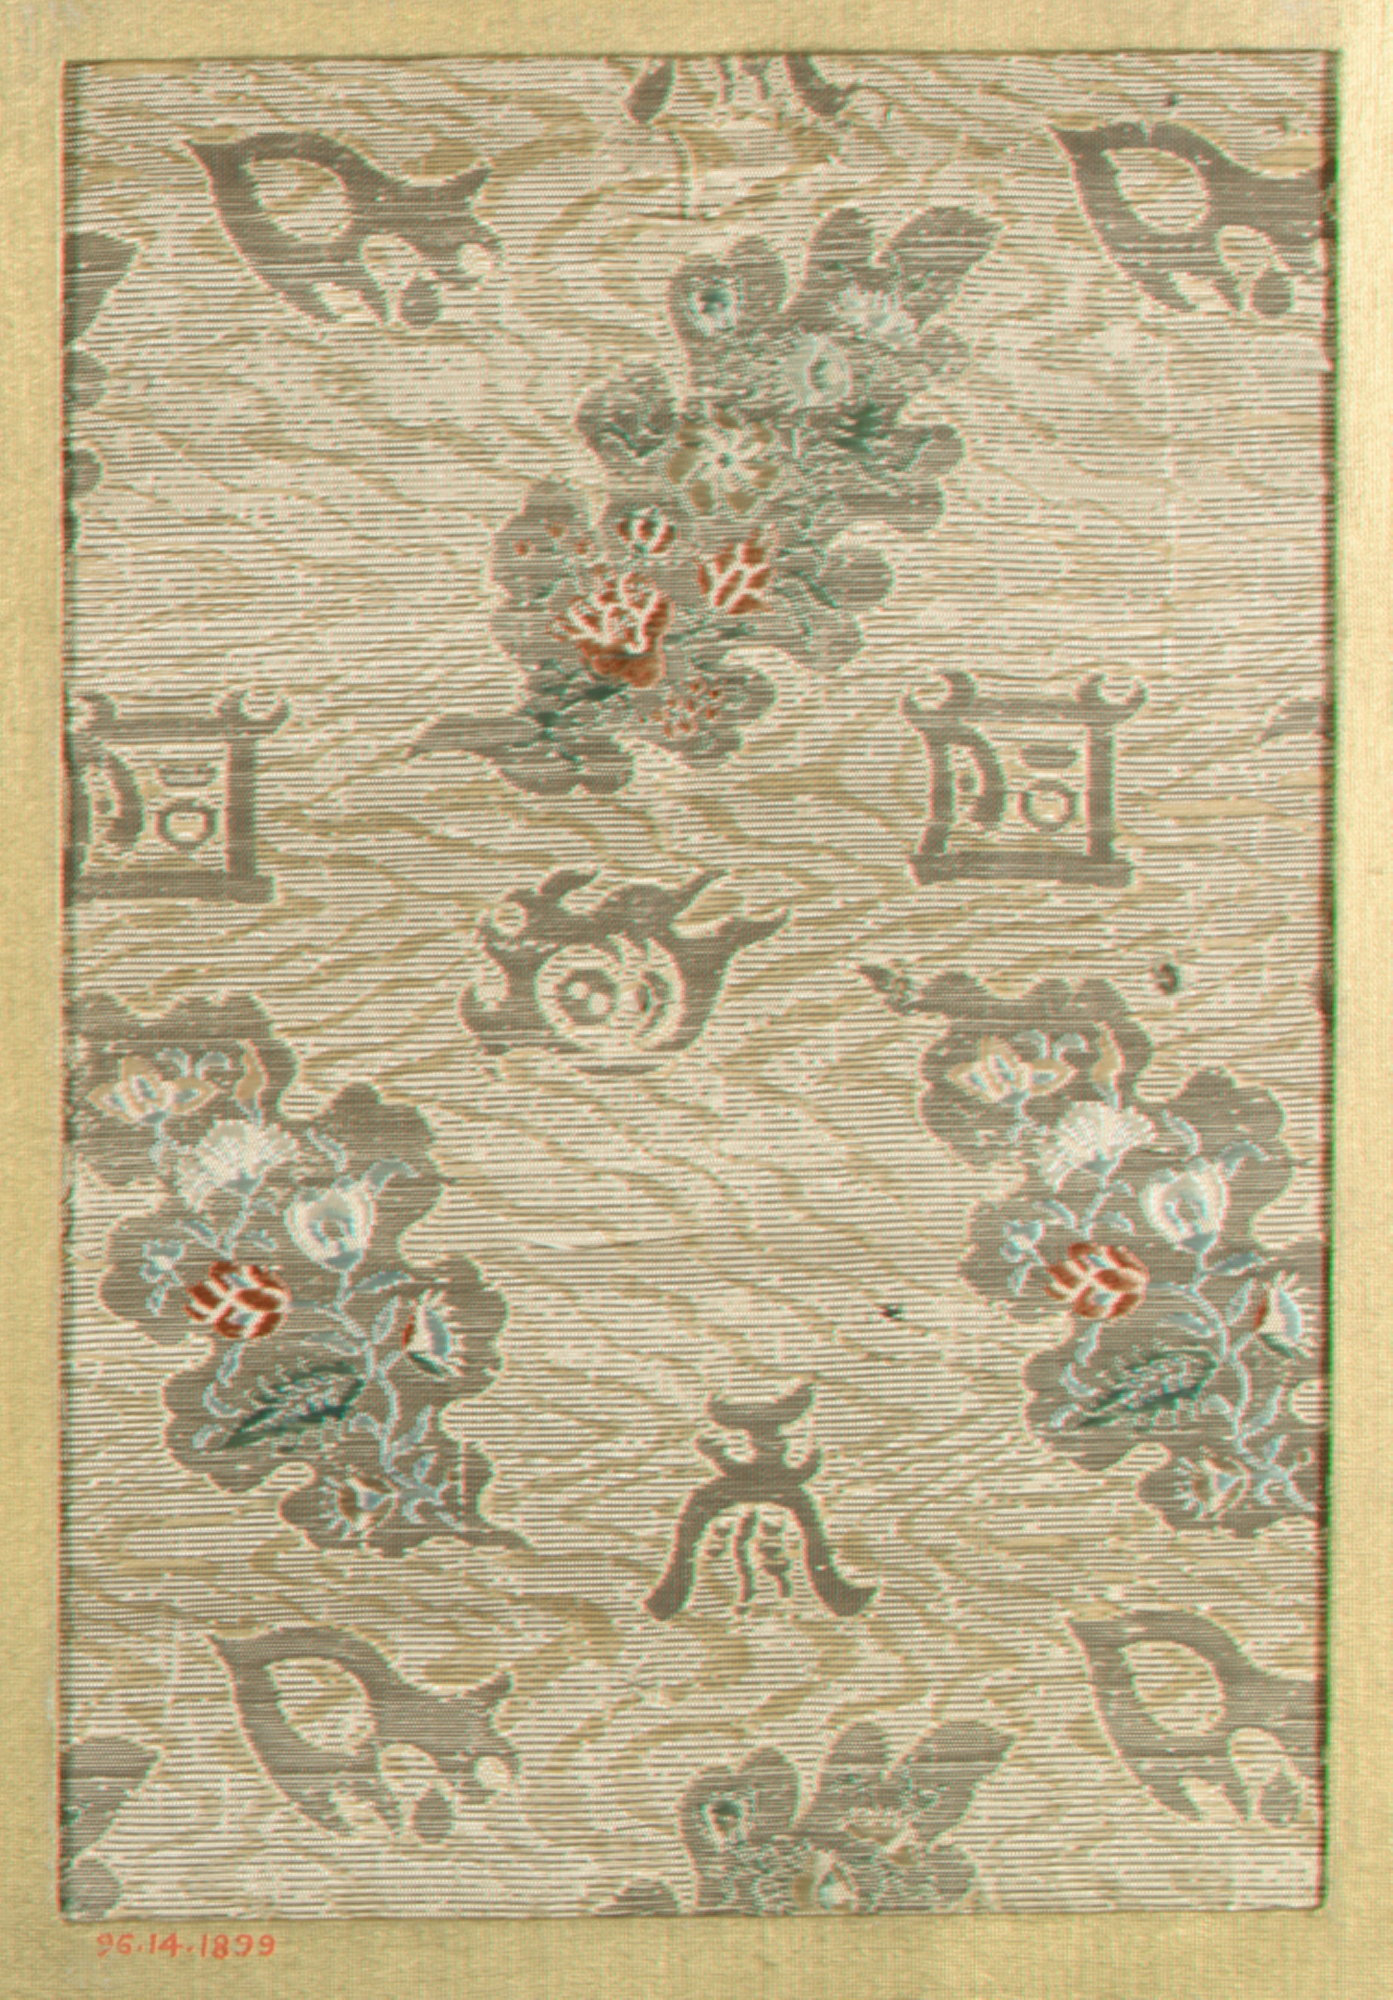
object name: piece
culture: japanese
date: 1701-1900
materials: silk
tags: plants